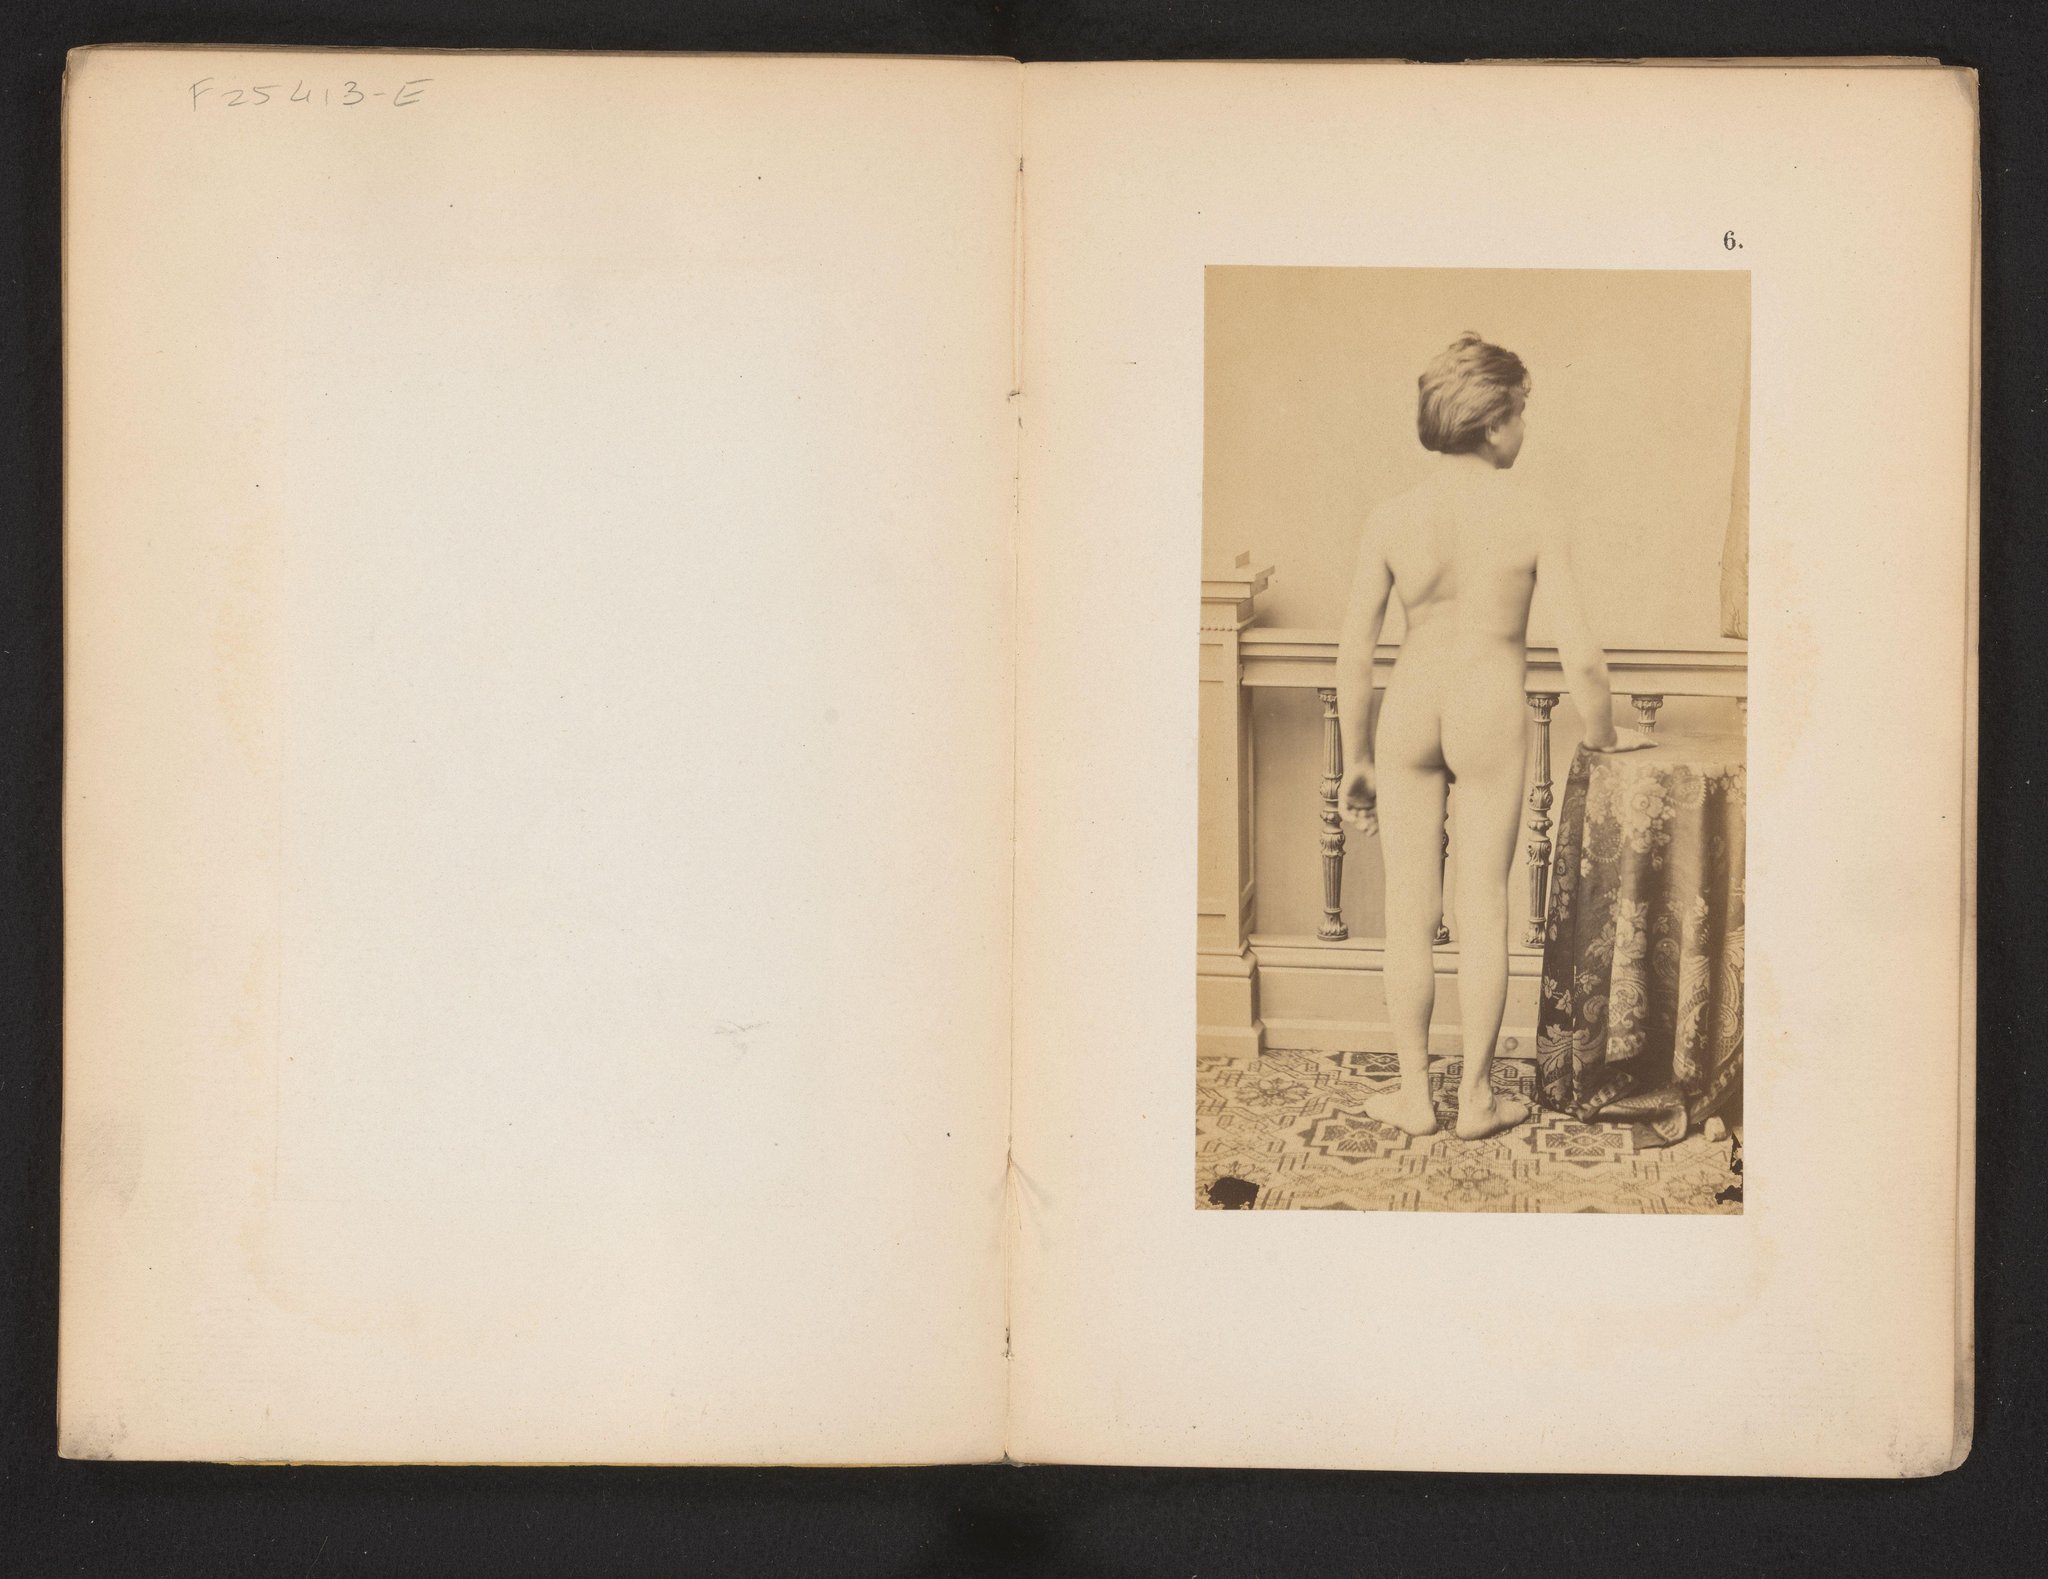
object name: page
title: Portret van een onbekende naakte jongen met heupafwijking, dorsaal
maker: Anonymous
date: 1858-1863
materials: paper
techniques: albumen print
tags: boy (child between toddler and youth), medical examination, medical treatment, historical persons not known by name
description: Foto op dertiende ongenummerde pagina na pagina 38.